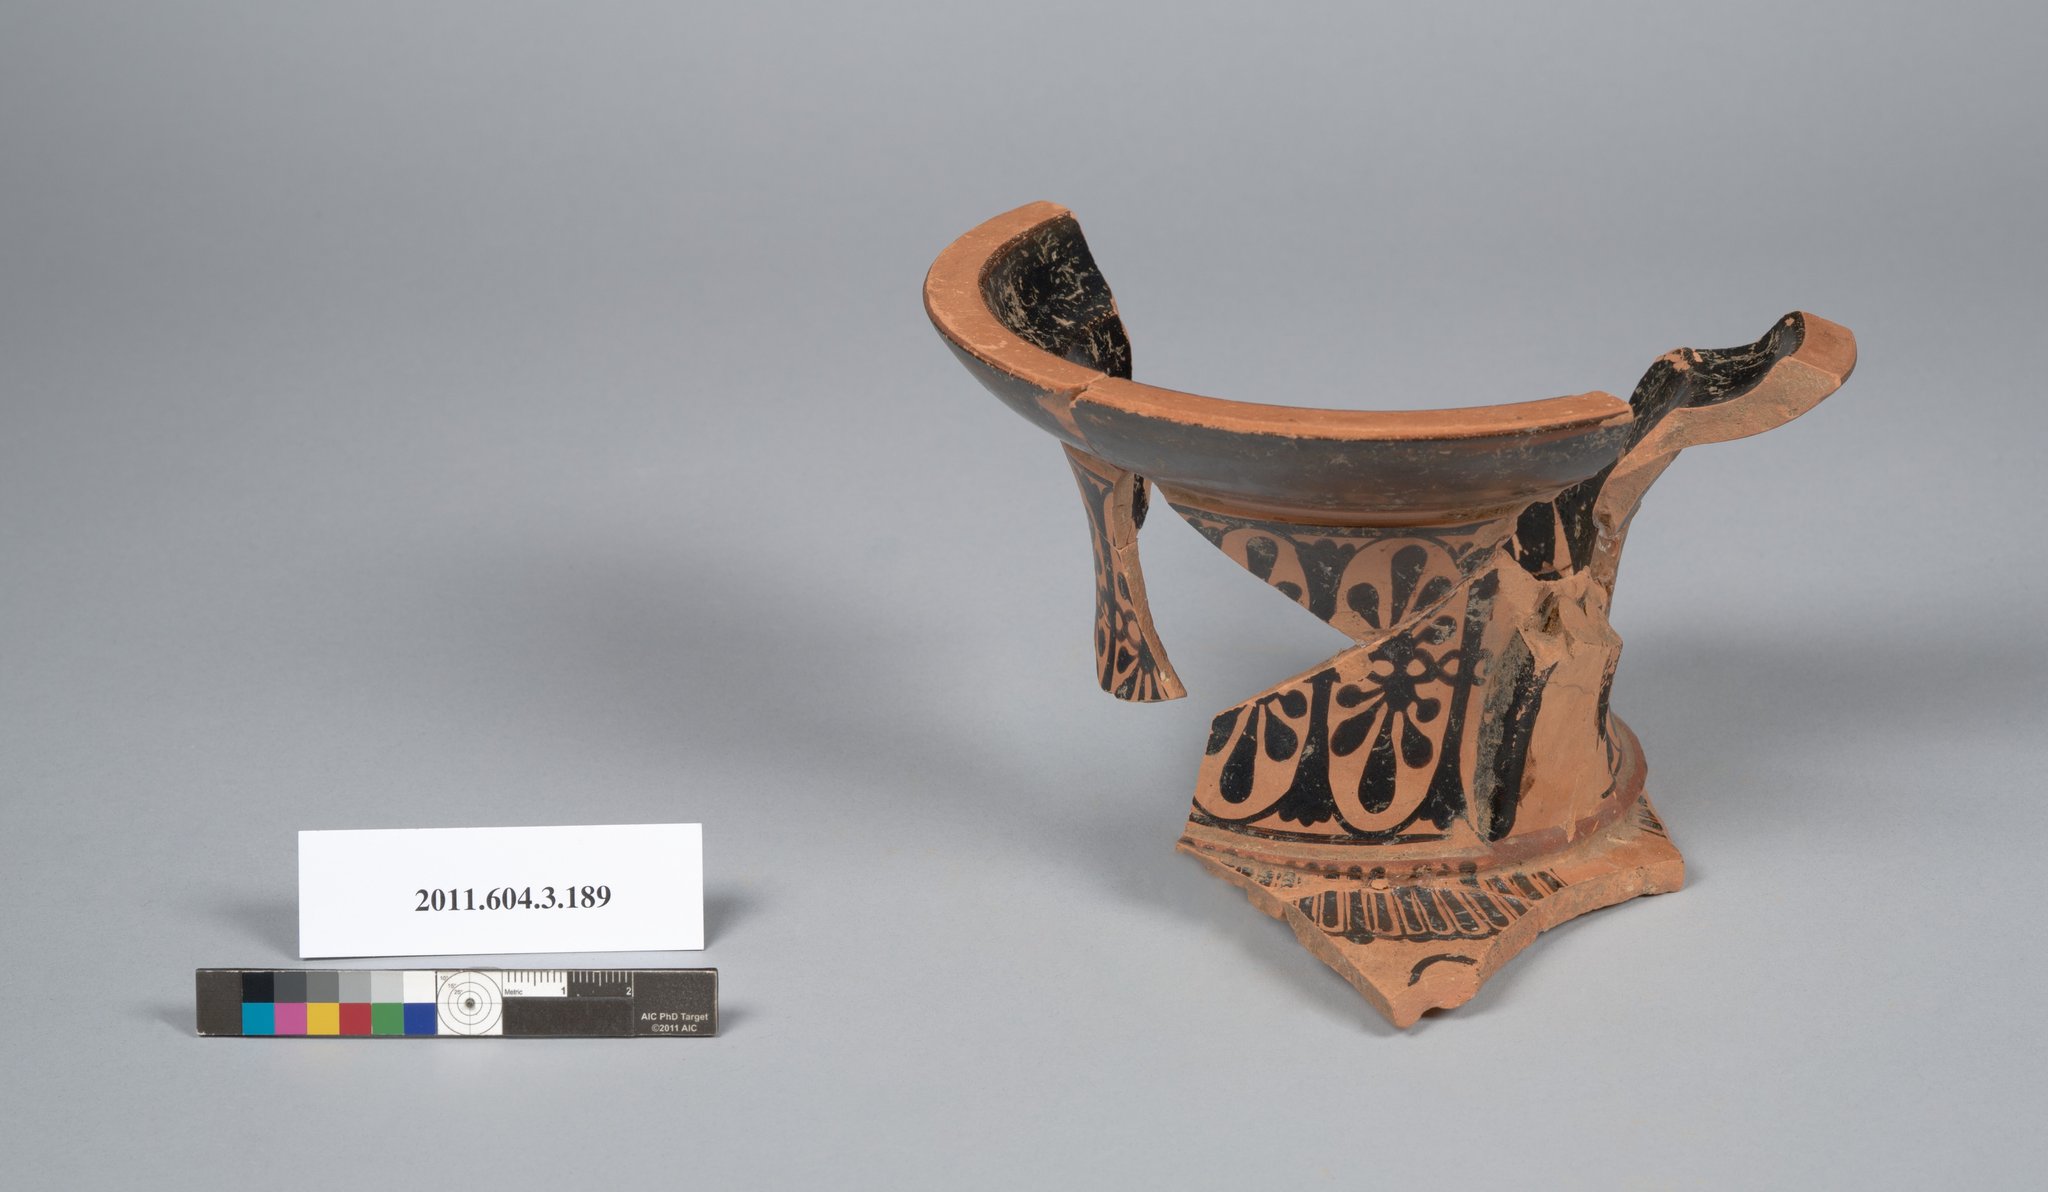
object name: neck amphora fragment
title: Terracotta fragment of a neck-amphora (jar)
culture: greek, attic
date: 510 BCE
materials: terracotta